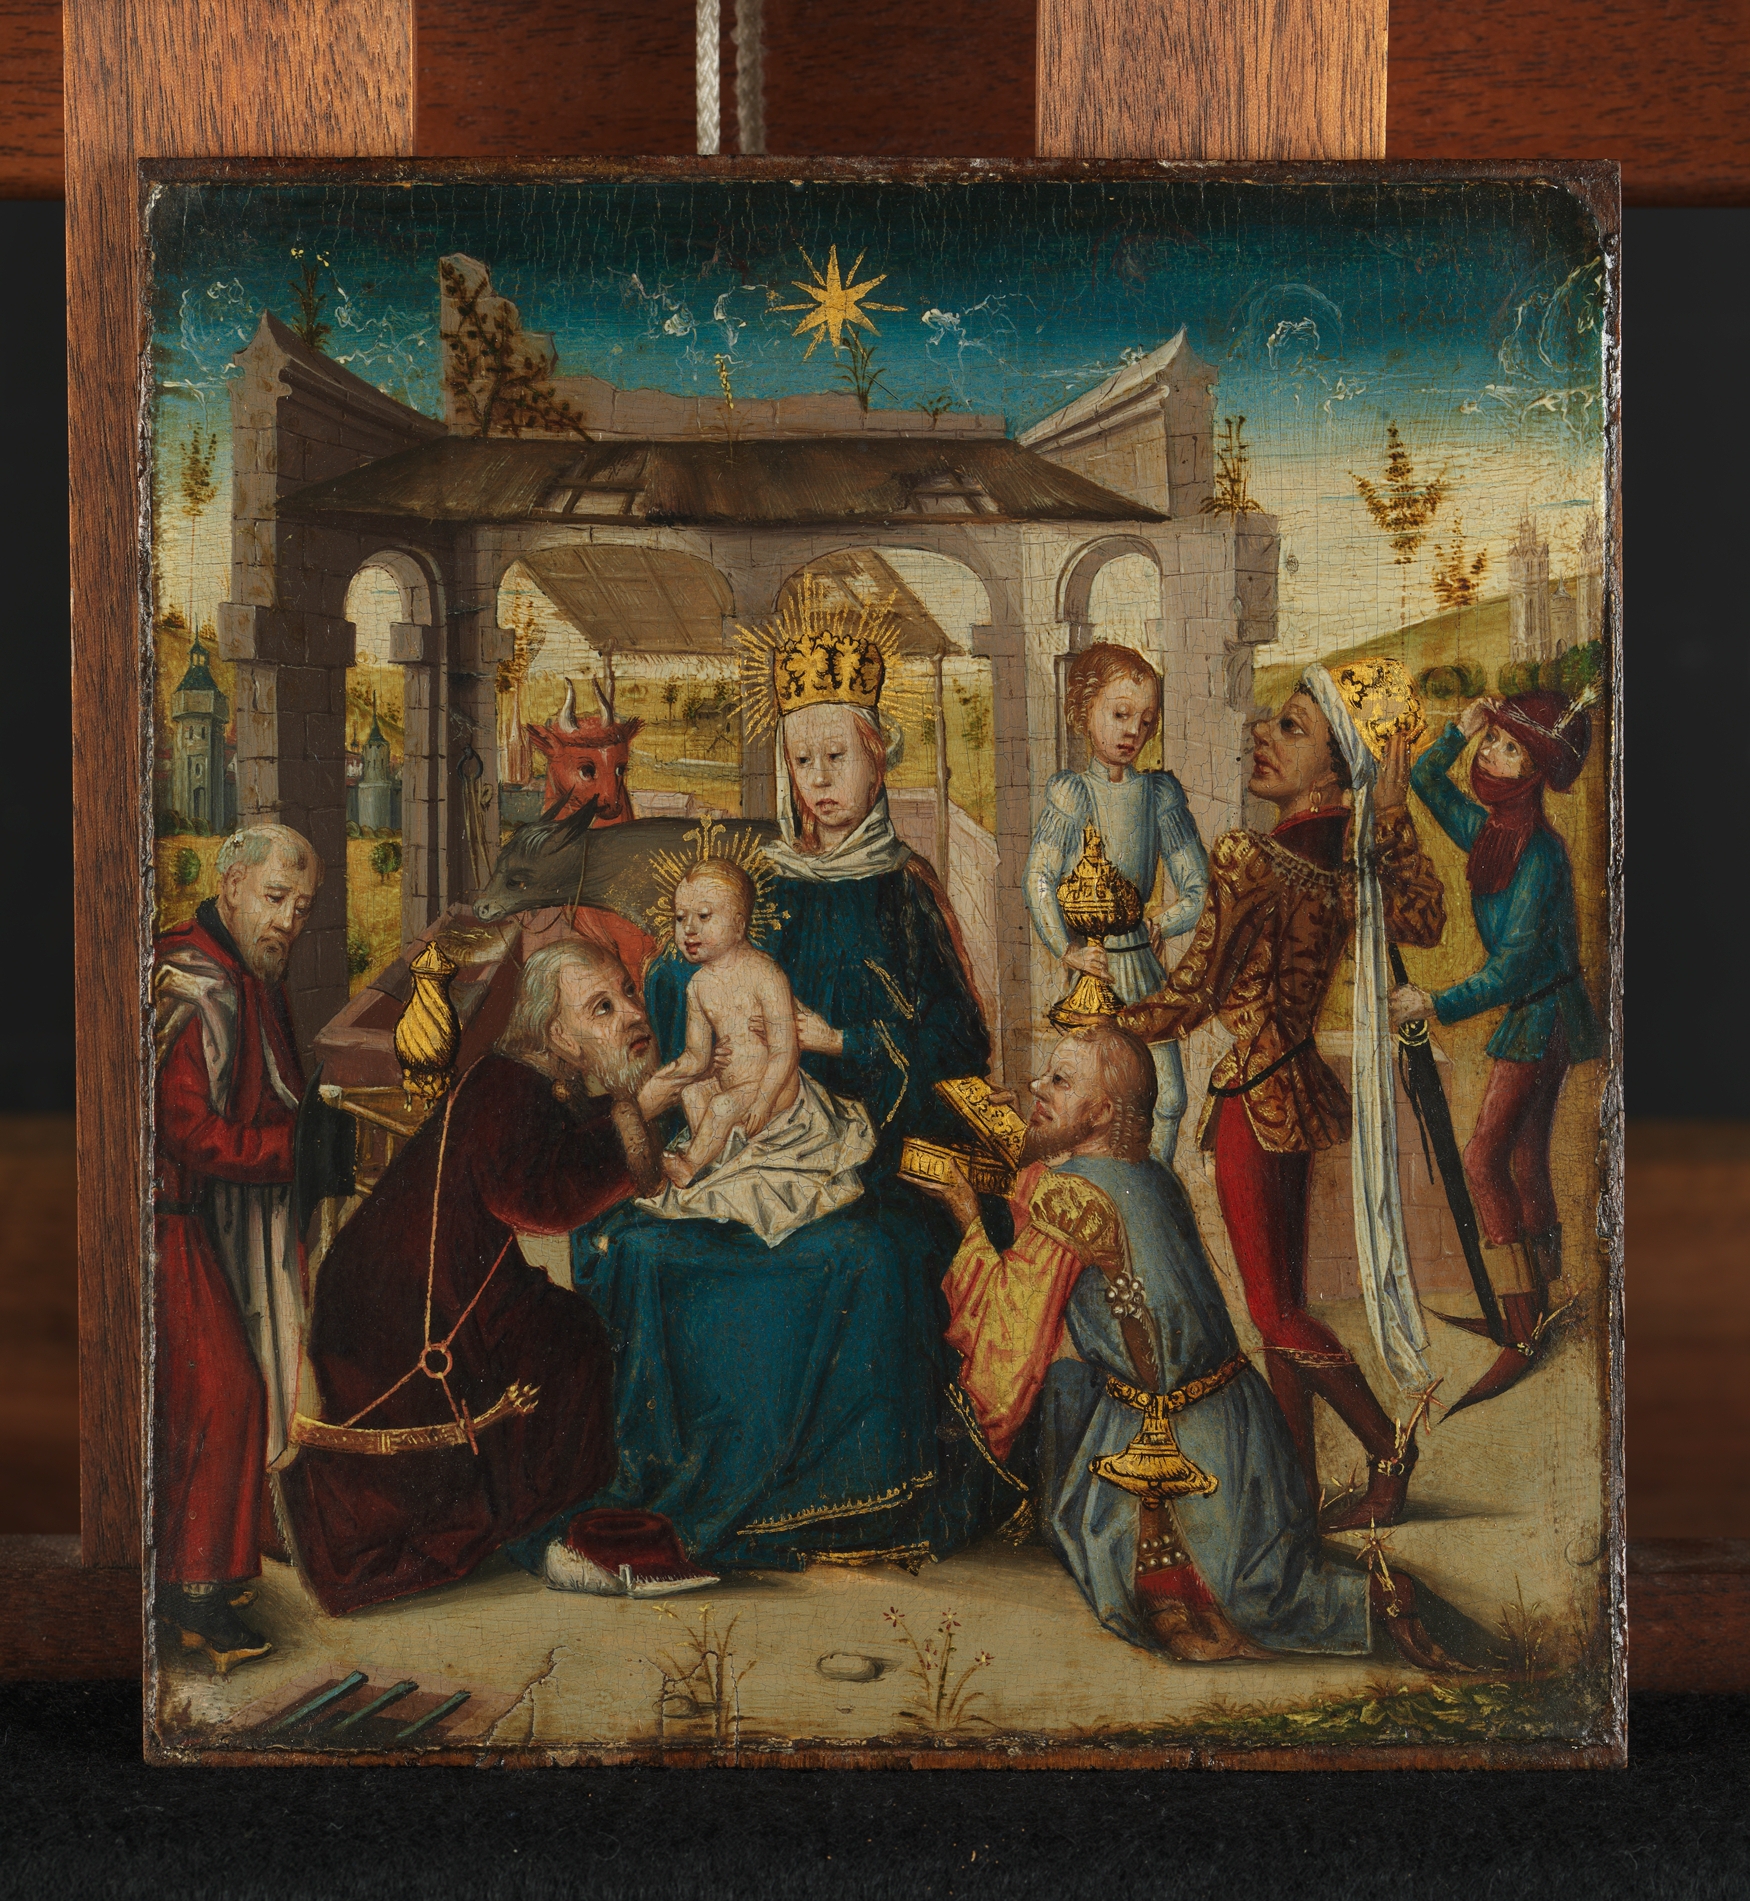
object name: painting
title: Adoration of the Magi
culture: german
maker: german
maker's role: artist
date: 1470-1490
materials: wood, gold, oil, panel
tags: men,madonna and child,adoration of the magi